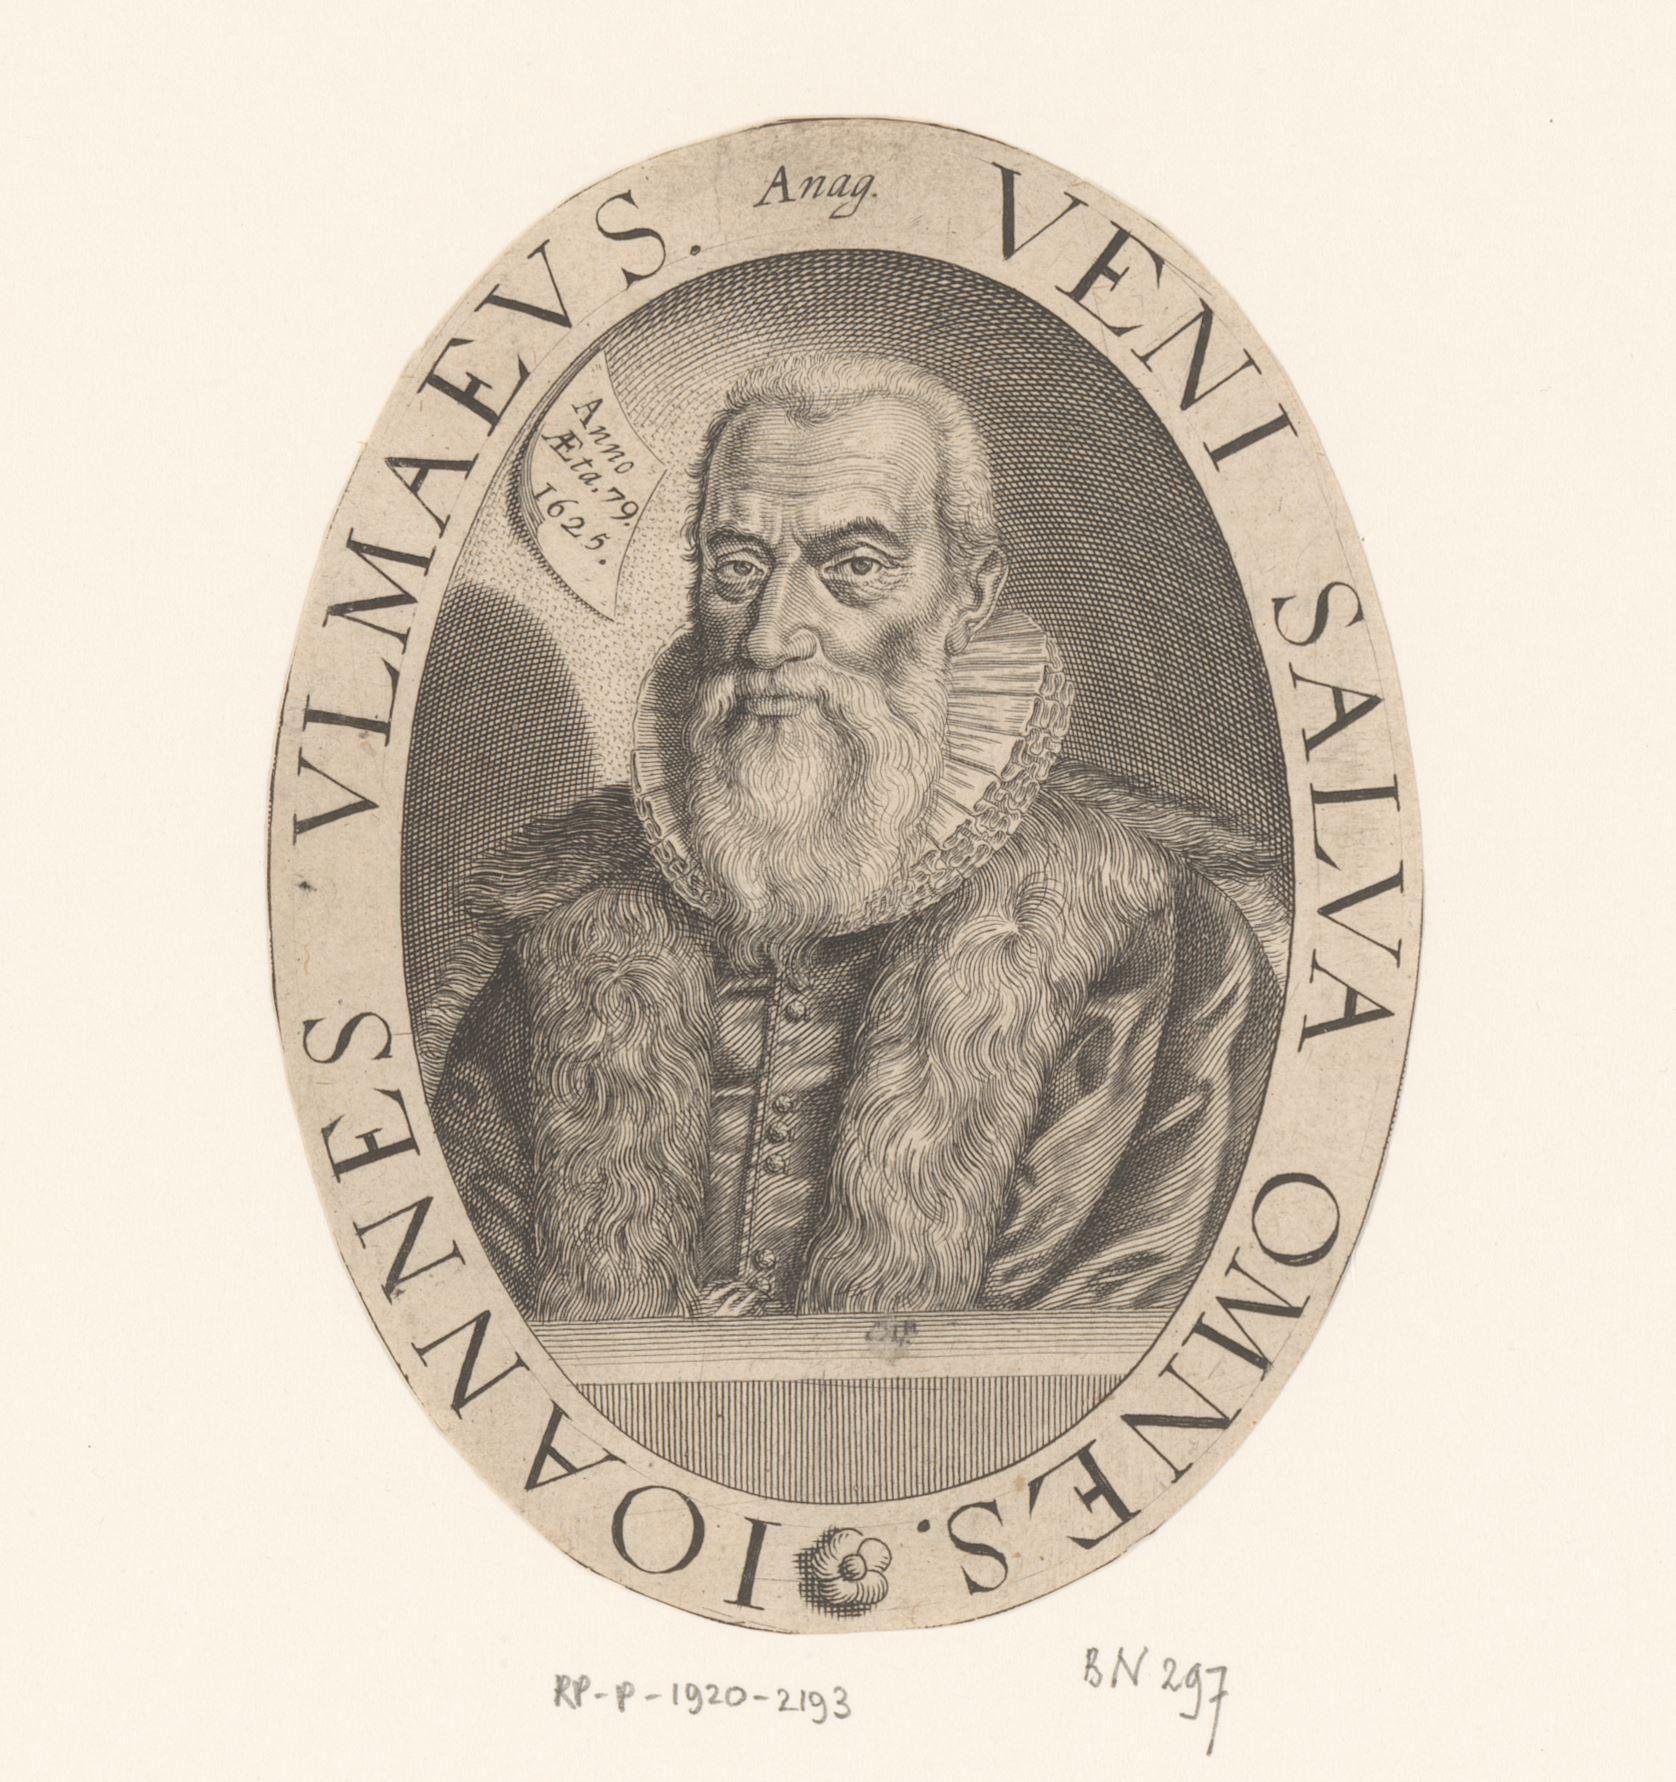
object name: print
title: Portret van Ioannes Ulmaeus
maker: michel lasne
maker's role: print maker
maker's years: 1590-1667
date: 1625-1667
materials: paper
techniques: engraving, etching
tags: historical persons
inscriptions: collector's mark: Lugt 2228